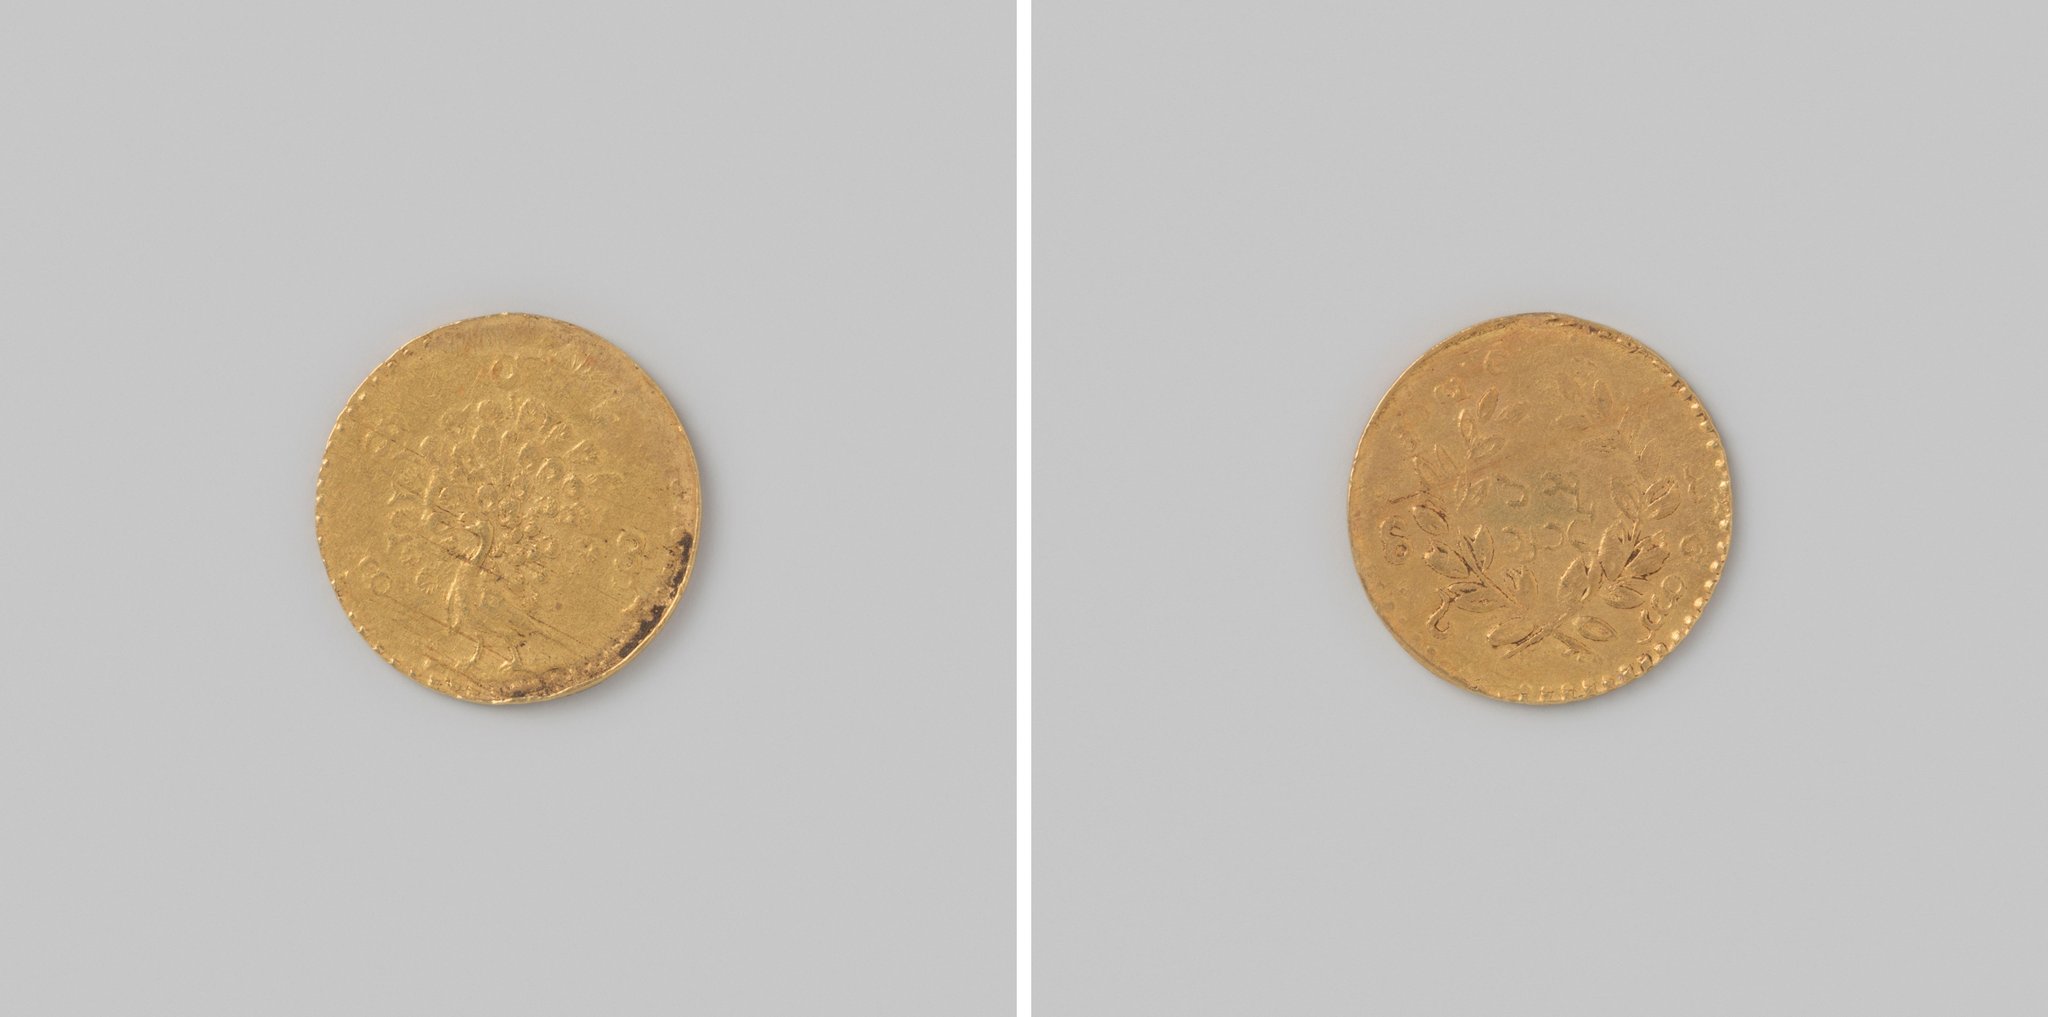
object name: achtste mohur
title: Birma, Mindon Min, 1/8 mohur of mu, 1214 [=1852]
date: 1852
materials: gold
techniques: striking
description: Gouden munt. Voorzijde: een pauw. Keerzijde: tussen twee gekruiste takken waarde-aanduiding in een regel, waaronder jaartal: 1214. Kartelrand.